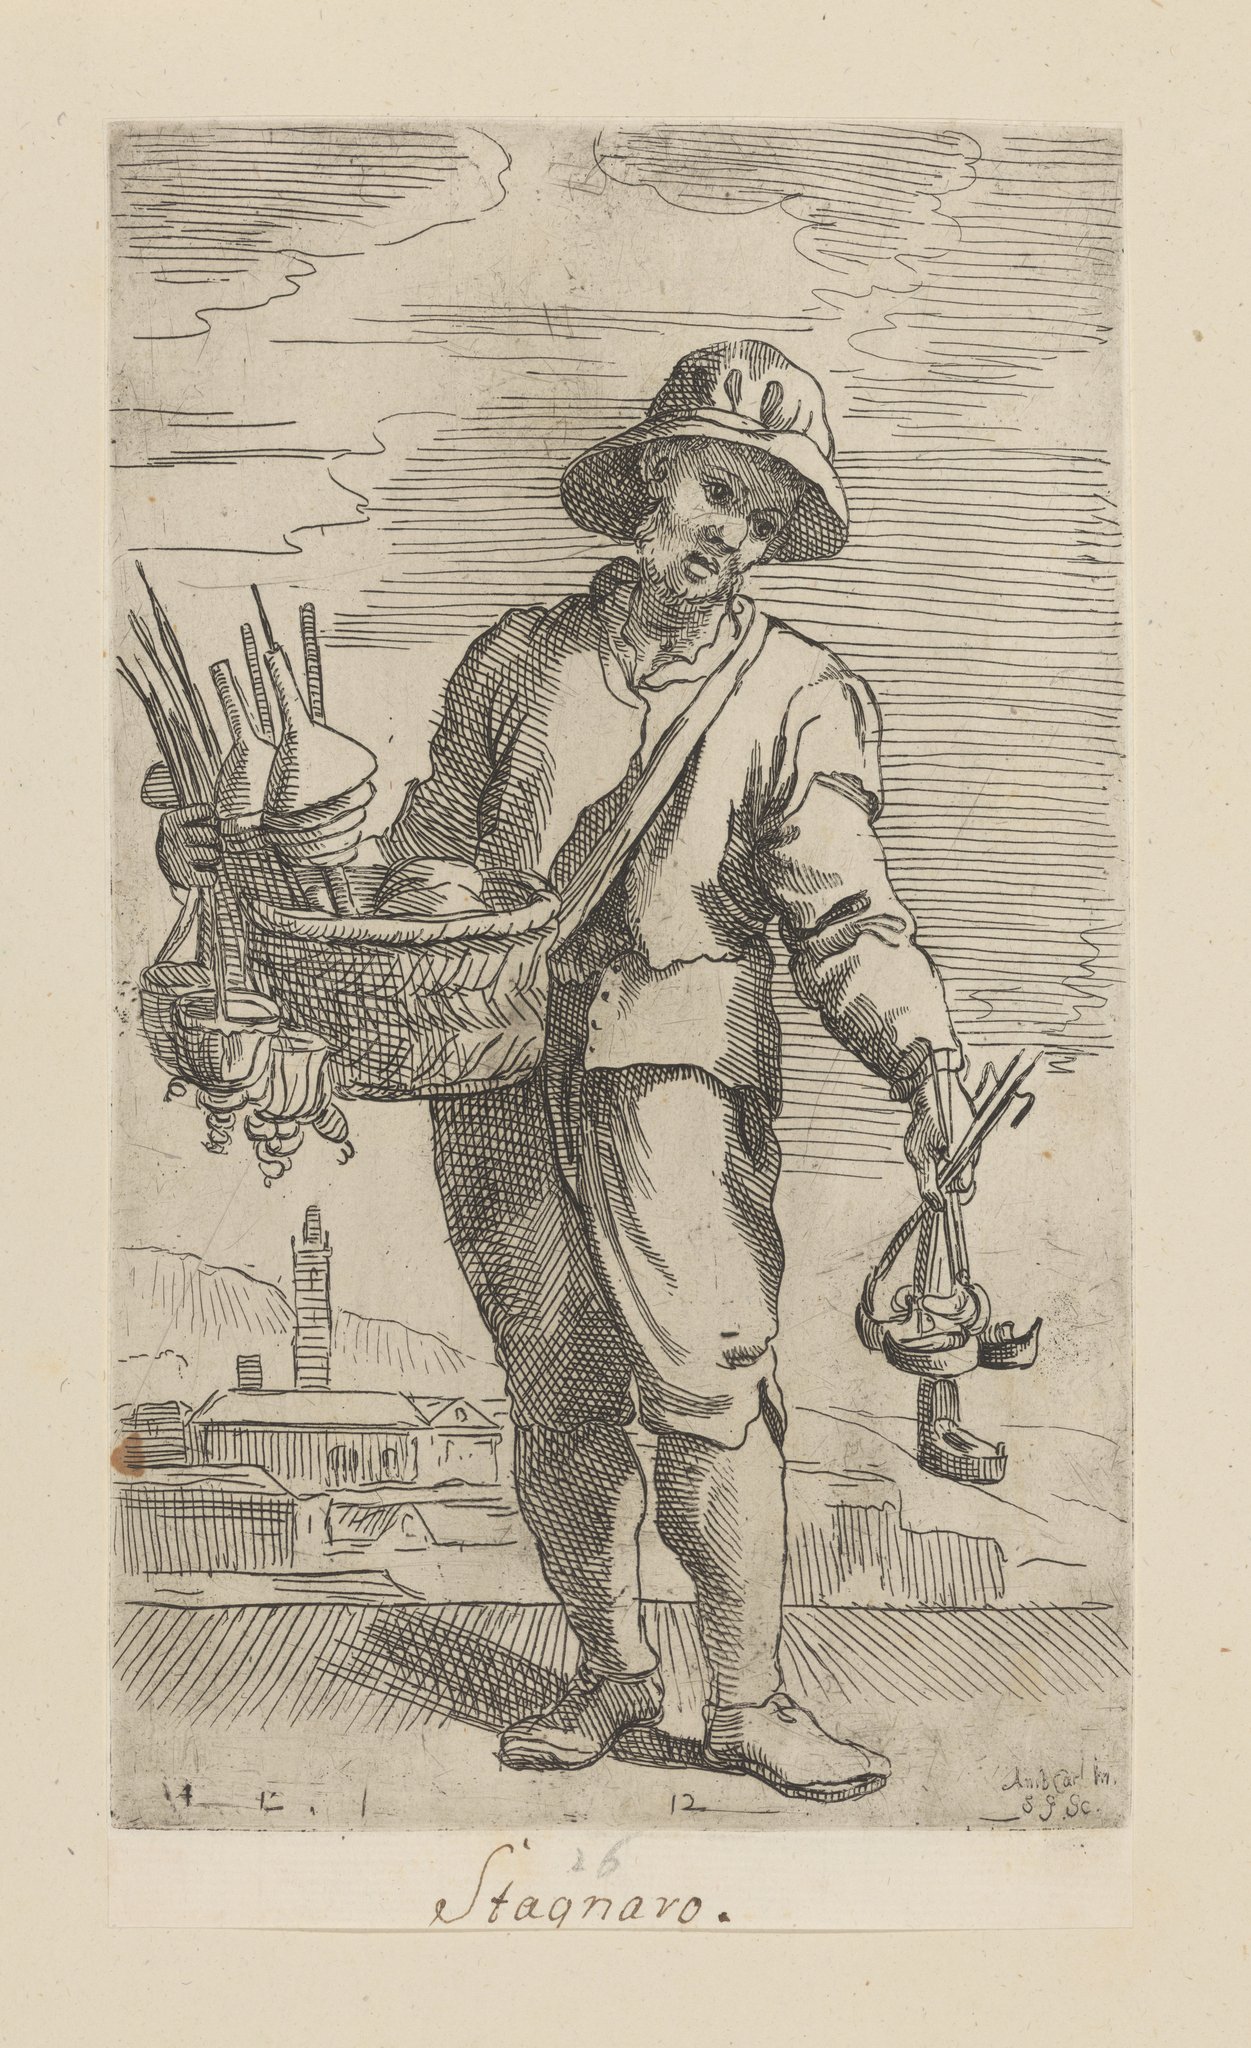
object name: print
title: Plate 12: Vendor of lamp and funnels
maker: simon guillain ii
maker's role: artist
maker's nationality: french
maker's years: 1618-1718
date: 1646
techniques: etching